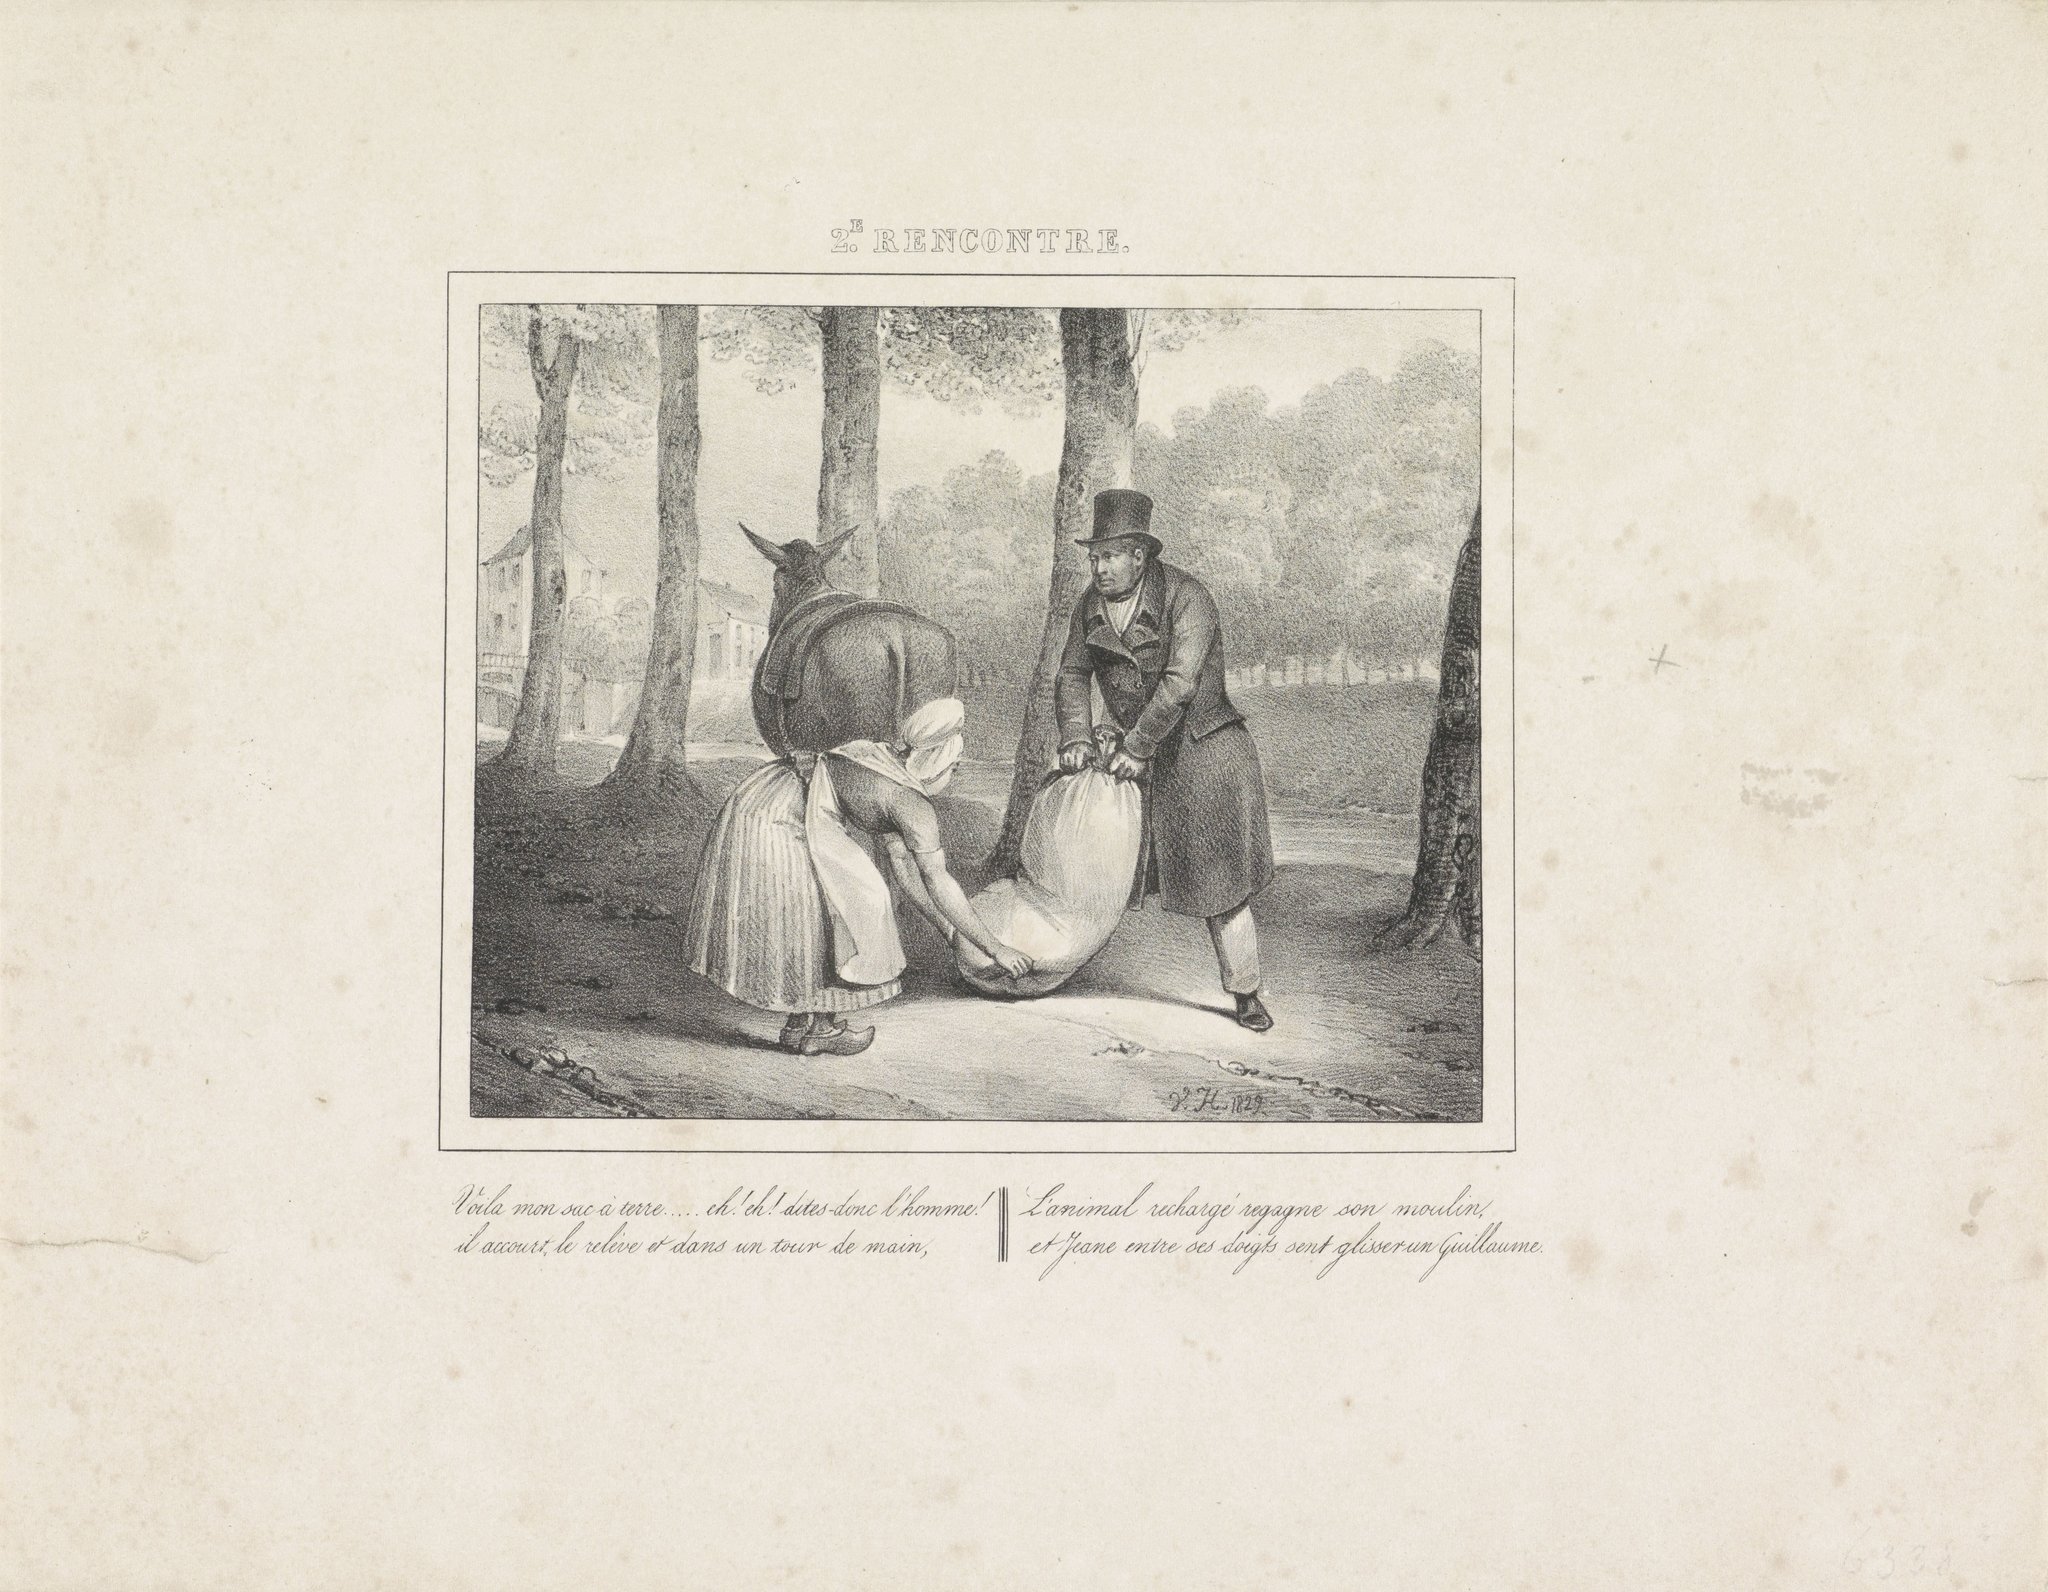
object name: print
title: Ontmoetingen met koning Willem I, 1829-1830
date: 1829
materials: paper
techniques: lithograph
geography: brussels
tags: berlin, william i of the netherlands, ruler in informal contact with his subjects, brussels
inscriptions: collector's mark: Lugt 2228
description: De koning helpt een vrouw uit Brabant een zware zak op te tillen die van haar ezel was gevallen. Met vierregelig onderschrift. Onderdeel van de serie van 24 platen met ontmoetingen met koning Willem I, verschenen onder de titel 'Les rencontres' in 1829-1830.